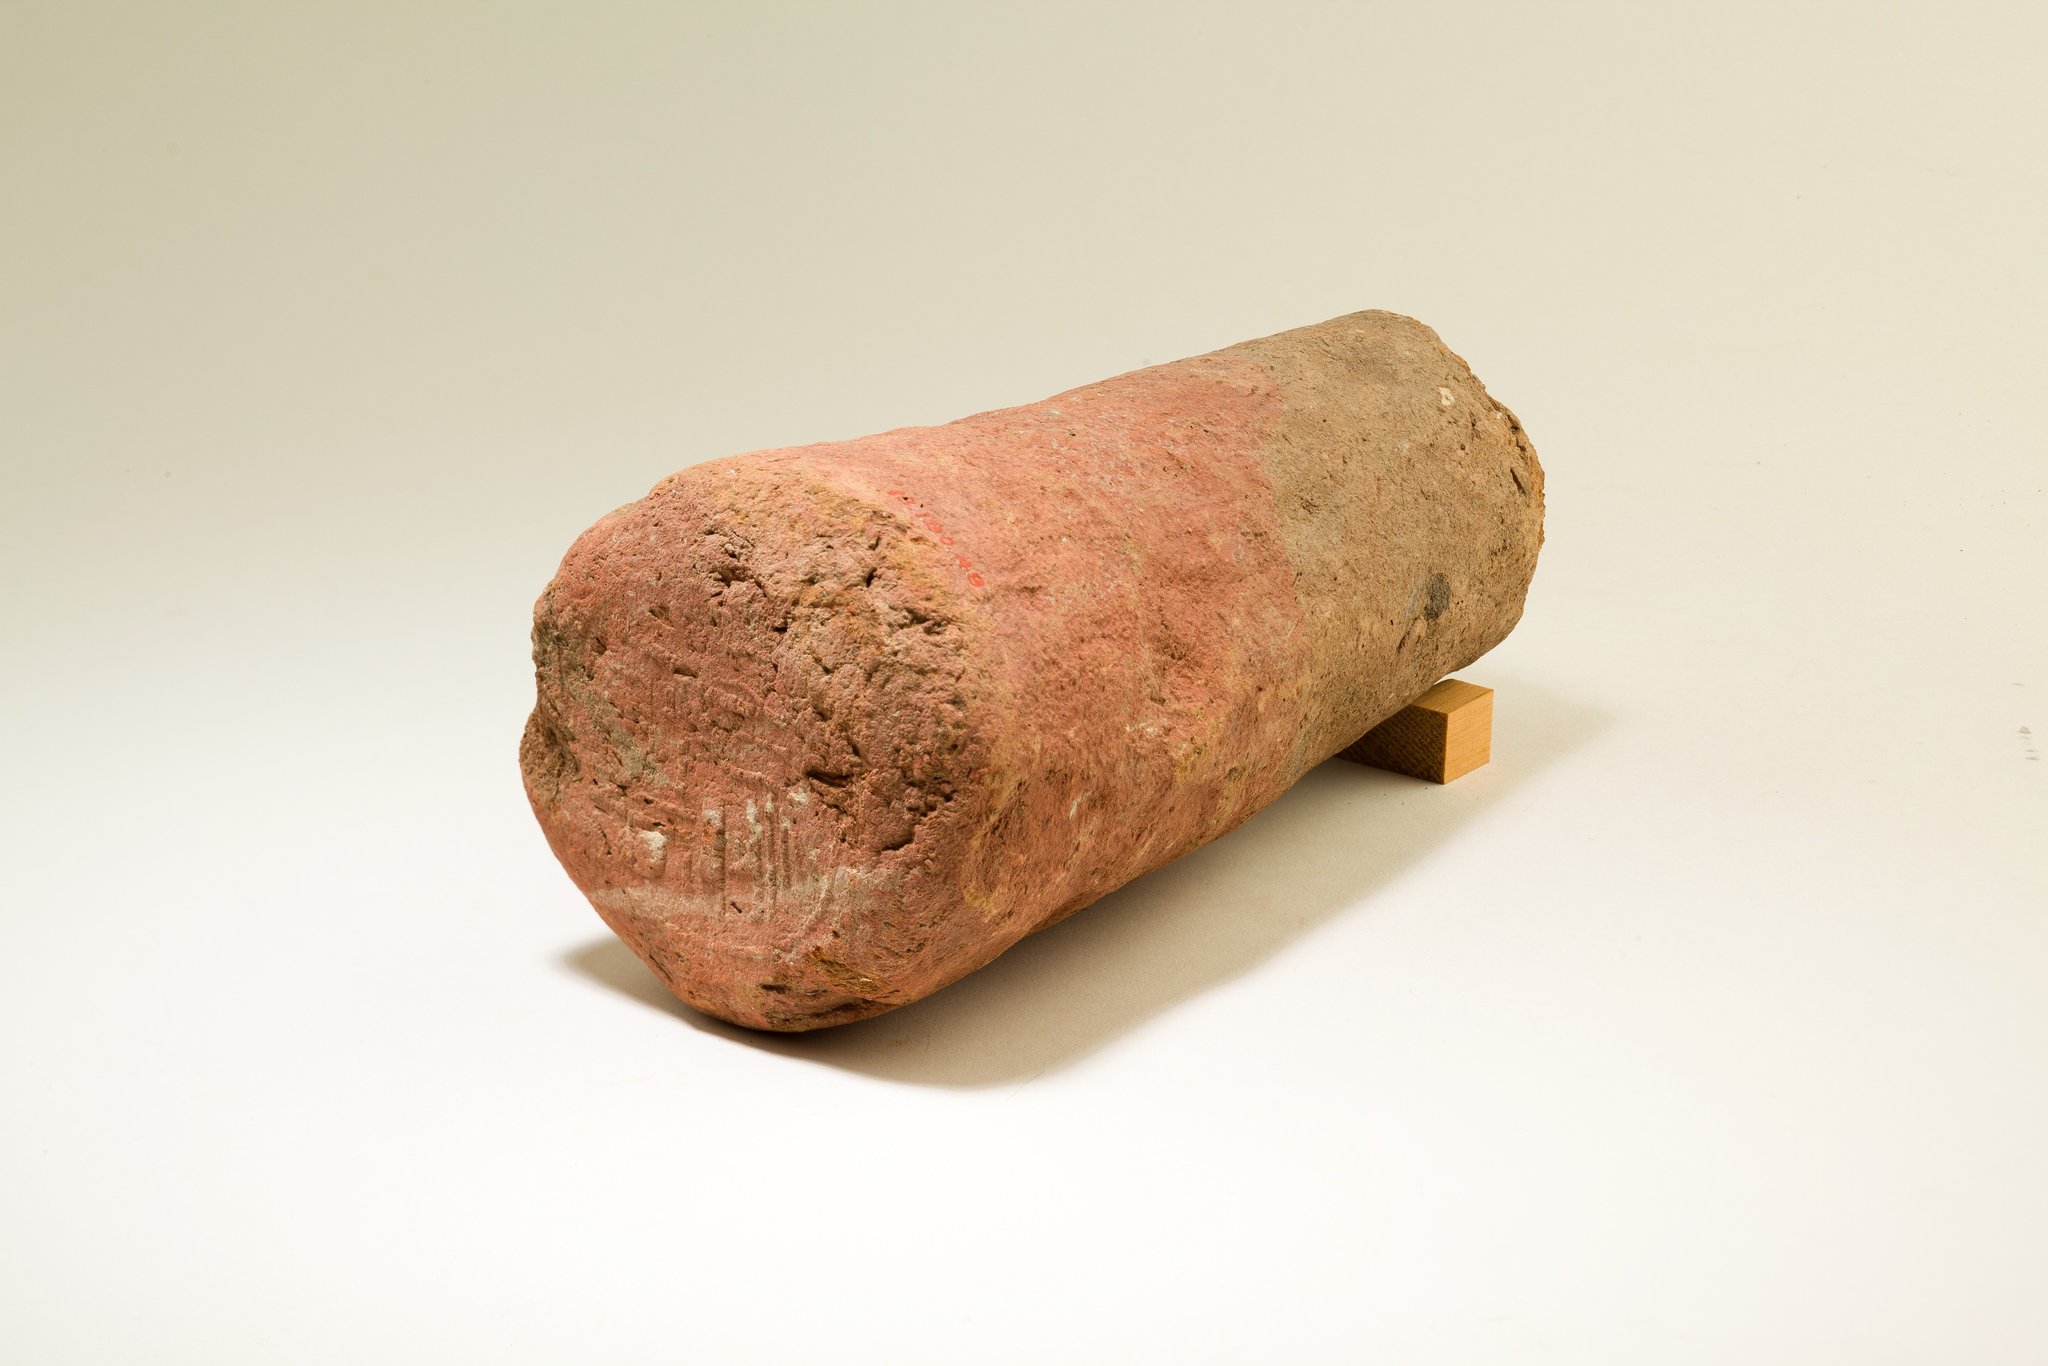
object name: cone, circular impression, kaemre, isy, steward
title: Funerary Cone of the Steward Kaemre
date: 1550-1295 BCE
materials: pottery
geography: egypt